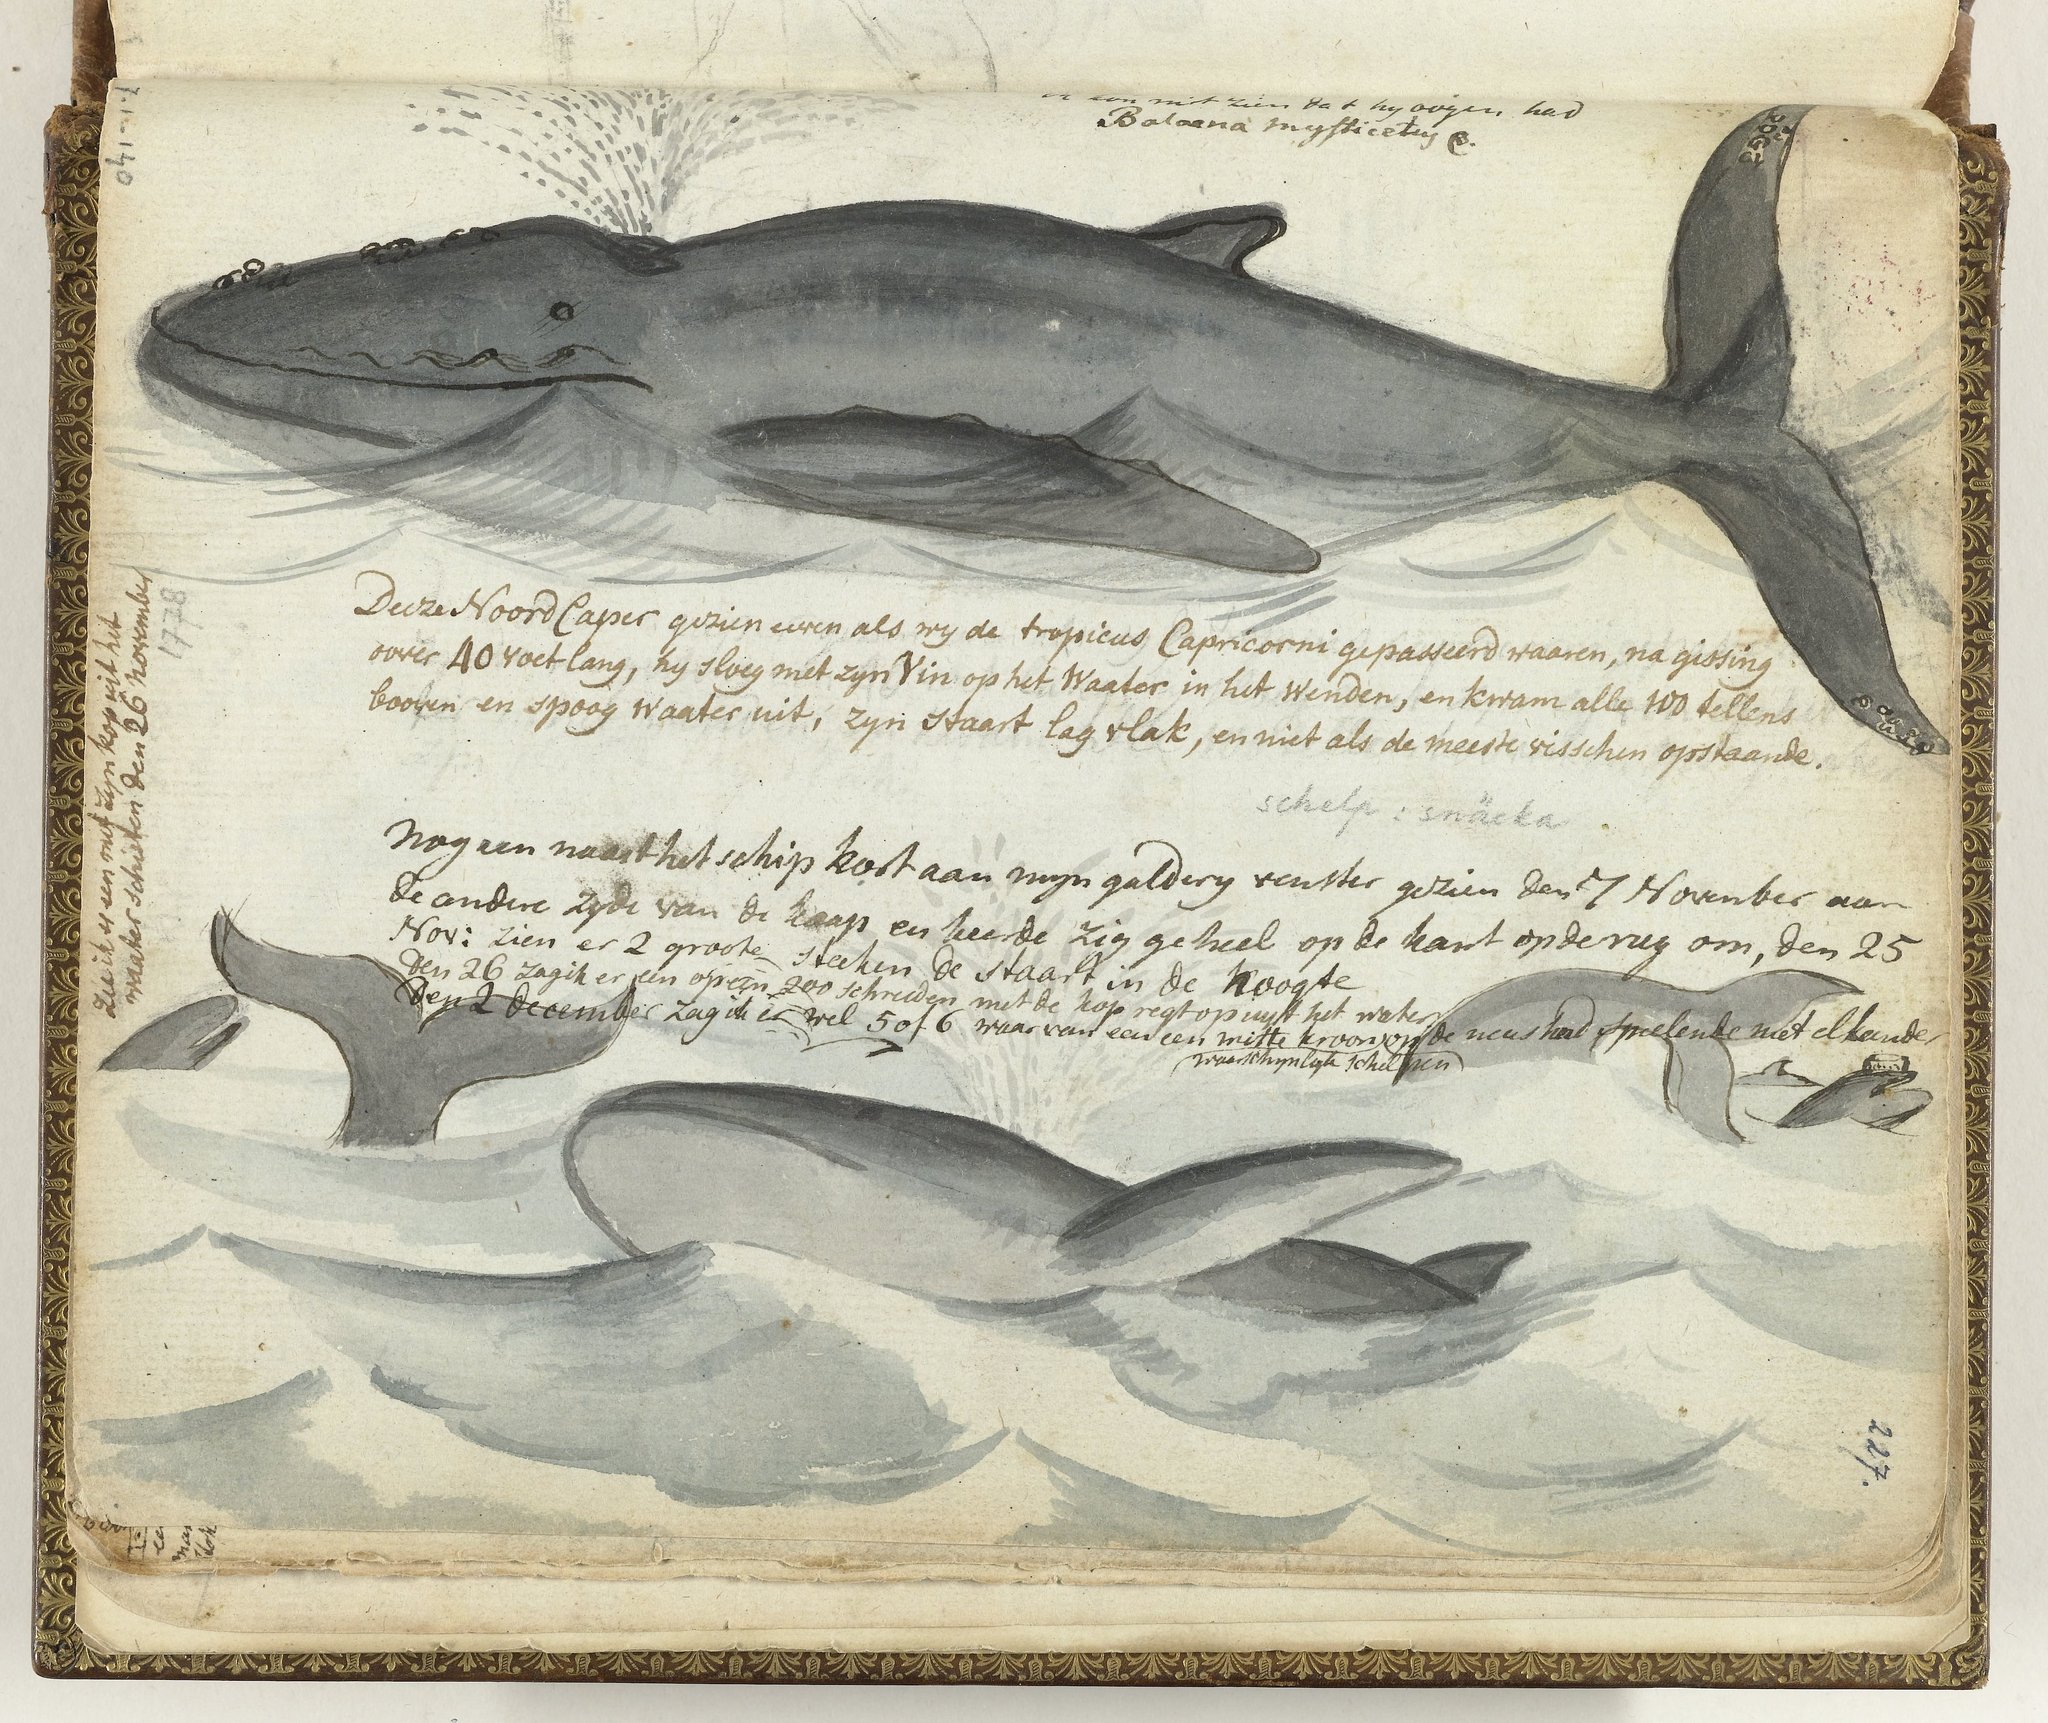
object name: drawing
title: Noordkapers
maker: jan brandes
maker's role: draughtsman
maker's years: 1743-1808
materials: ink, paper, pencil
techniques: brush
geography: atlantic ocean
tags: swimming mammals: whale, atlantic ocean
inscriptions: inscription: ‘nog een naast het schip kort aan myn galdery venster gezien den 7 november aan de andere zyde van de kaap en keerde zig geheel op de kant op de rug om, den 25 Nov: zien er 2 groote steeken de staart in de hoogte. den 26 zag ik er een op een 200 schreeden met de kop regt op uijt het water. den 2 december zag ik er wel 5 of 6 waarvan een een witte kroon waarschynlyk schelpen op de neus had speelende met elkander.’, inscription: ‘Deeze NoordCaper gezien eeven als wy de tropicus Capricorni gepasseerd waaren, na gissing oover 40 voet lang, hy sloeg met zyn Vin op het waater in het wenden, en kwam alle 100 tellens booven en spoog waater uit, zyn staart lag vlak, en niet als de meeste visschen opstaande.’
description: Blauwgrijze tekening van een walvisachtige zeevis en een groep van diezelfde vissen, genaamd 'noordkapers'. Met opschriften. Onderdeel uit het schetsboek van Jan Brandes, dl. 1 (1808), p. 227.